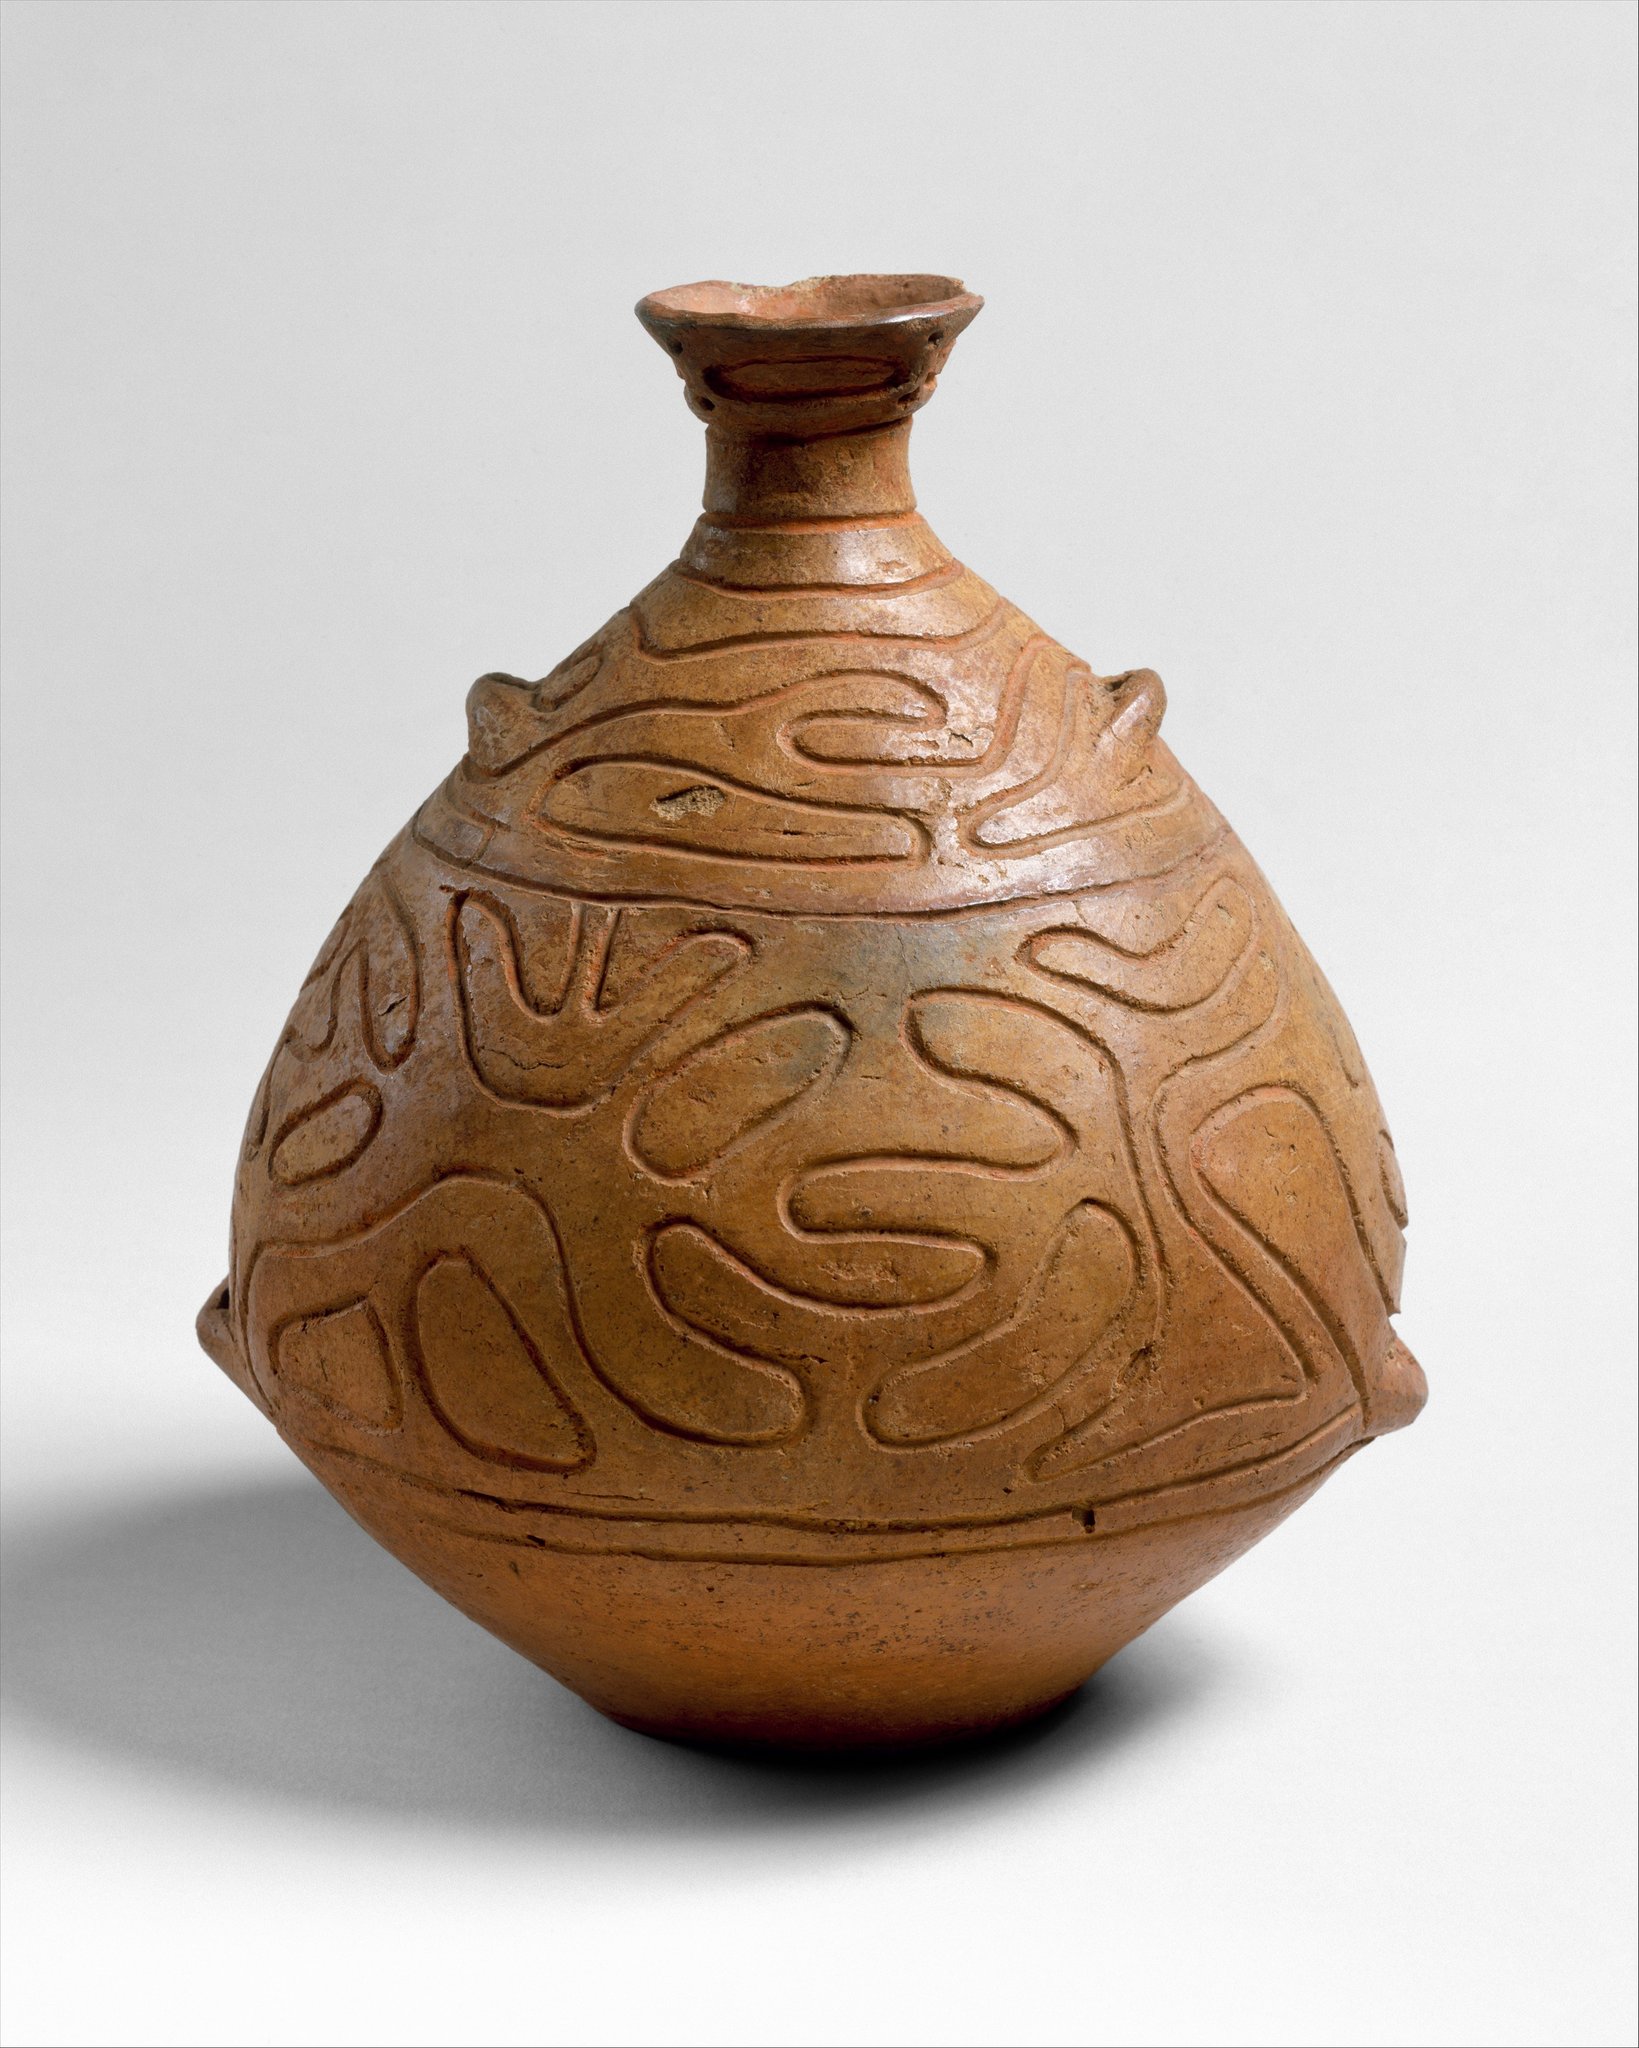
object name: jar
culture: japanese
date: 2500-1000 BCE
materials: earthenware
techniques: incising